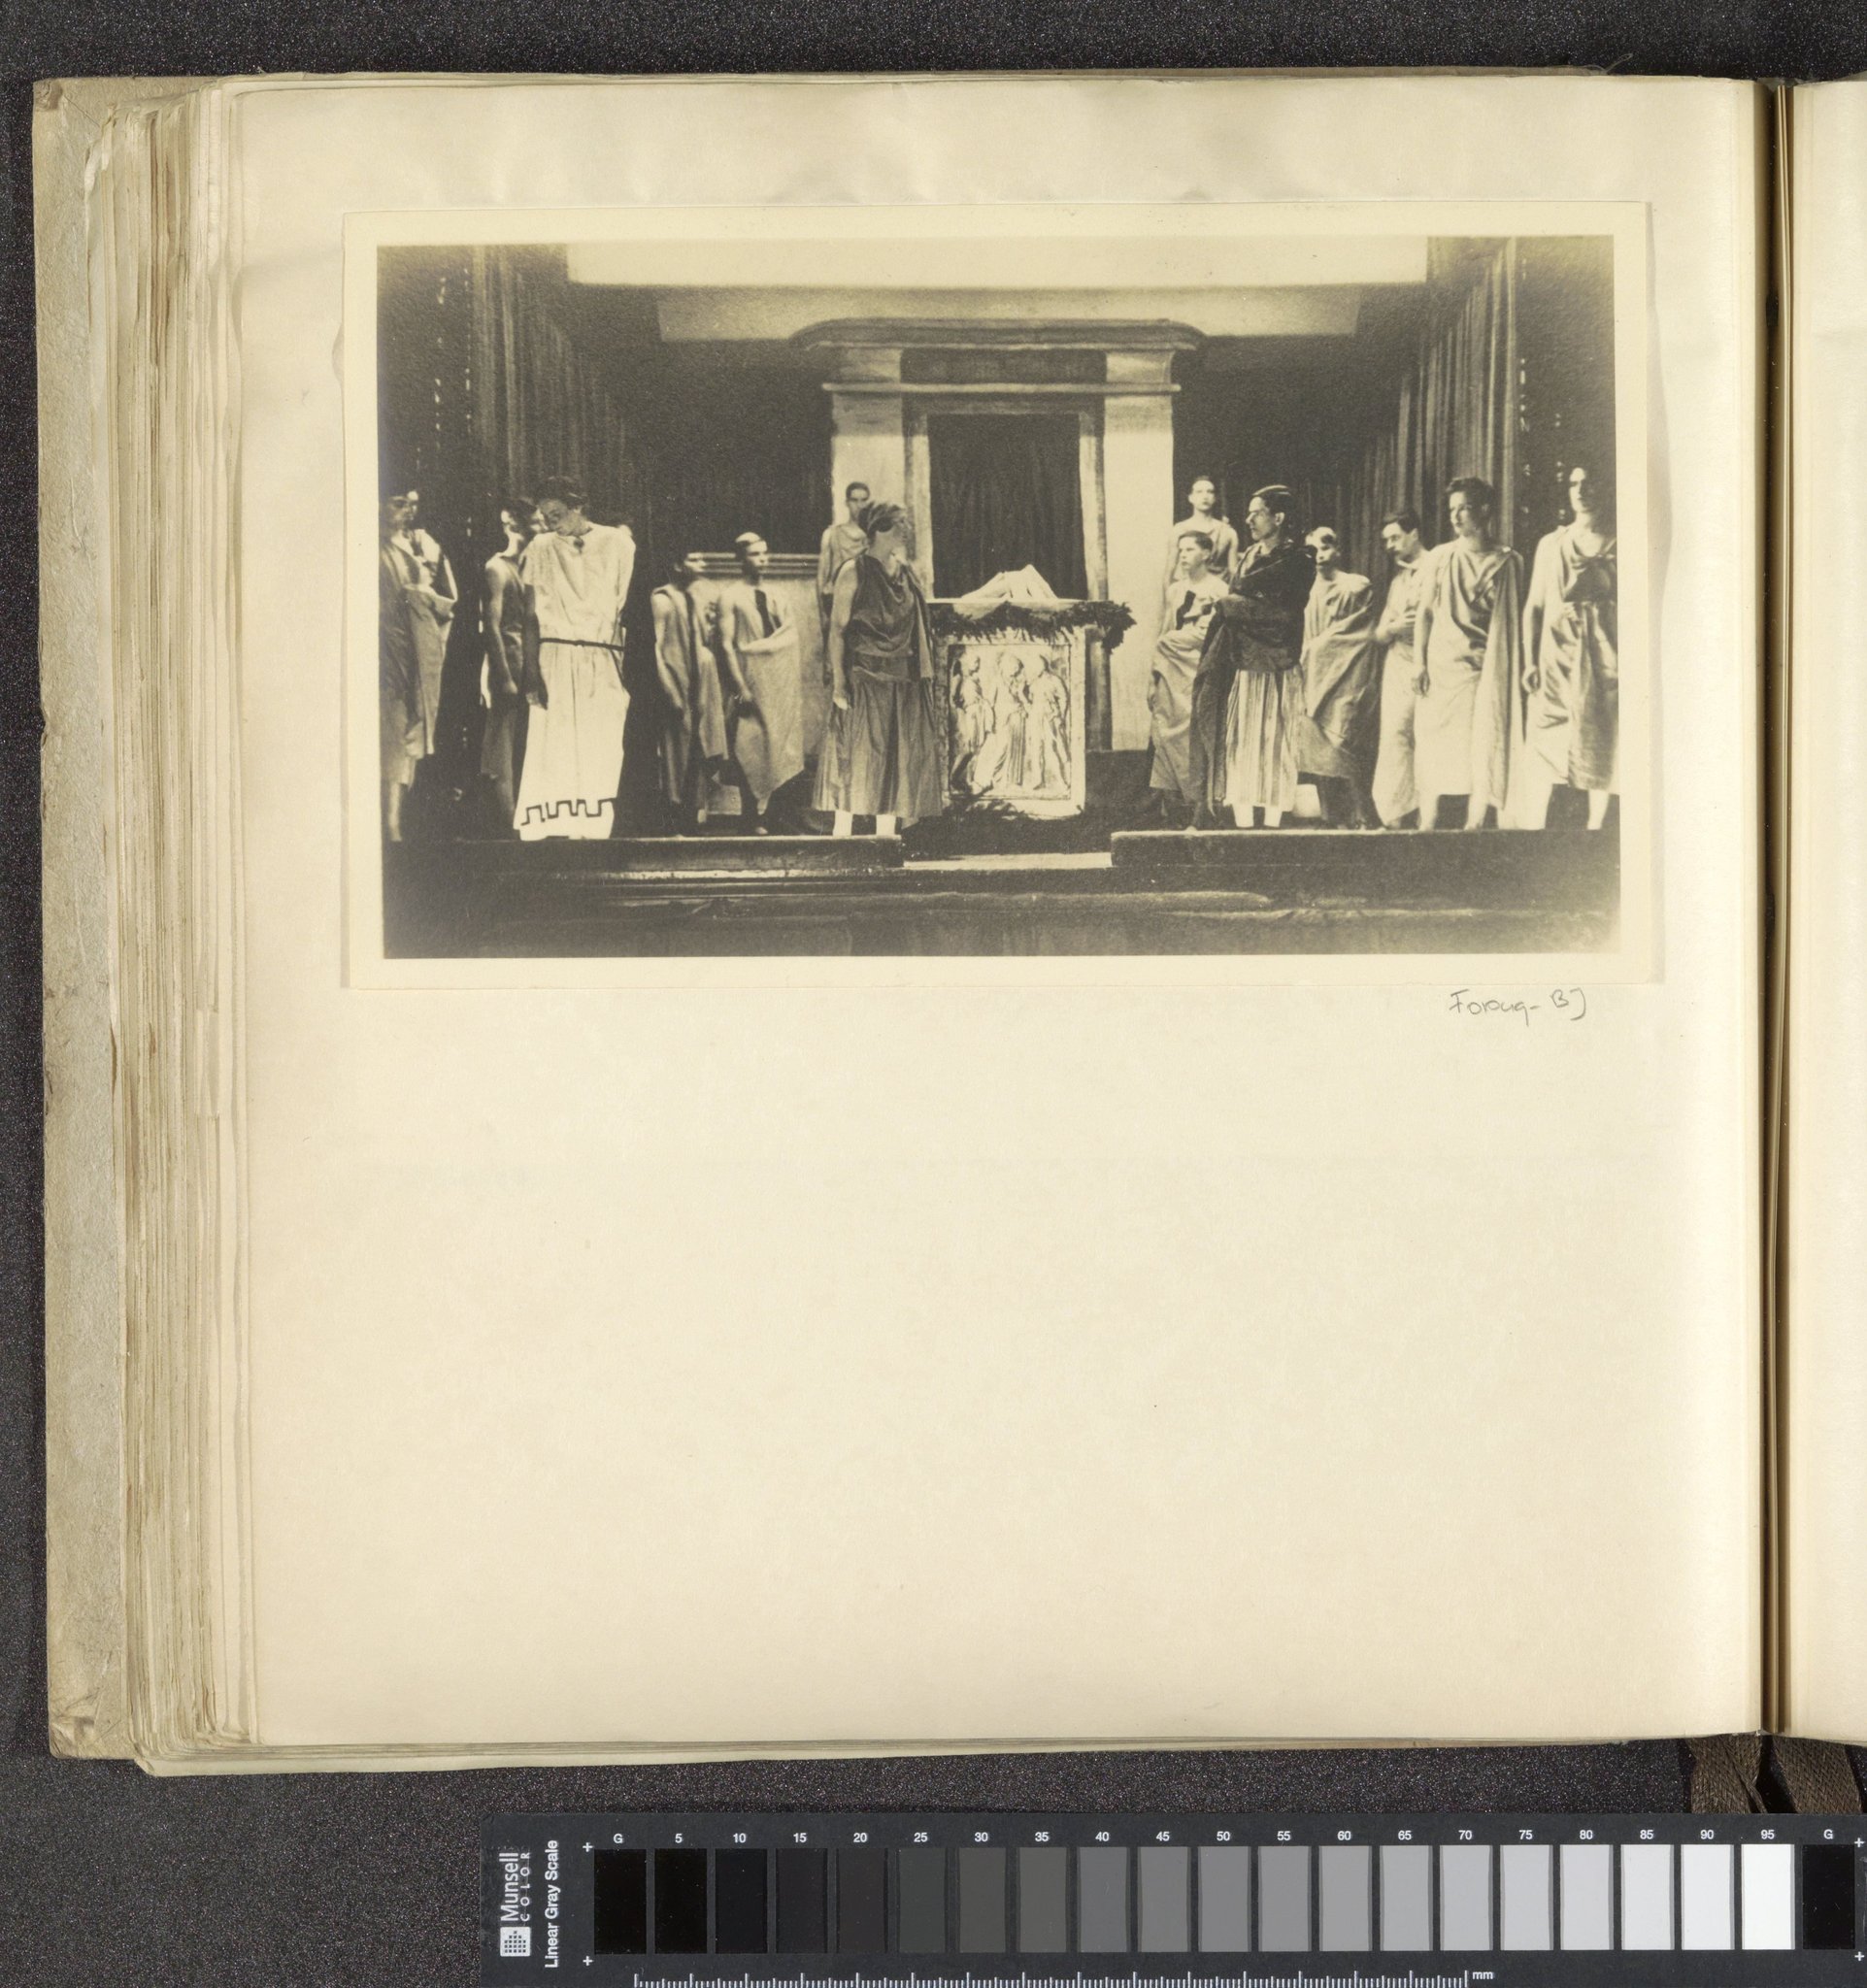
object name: photograph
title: Leerlingen van Schule Schloss Salem tijdens een dramatische uitvoering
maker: Anonymous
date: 1929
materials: photographic support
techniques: gelatin silver print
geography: salem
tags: performance, theatre, theatrical performance, historical costume, education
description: Onderdeel van Fotoalbum van Schule Schloss Salem.